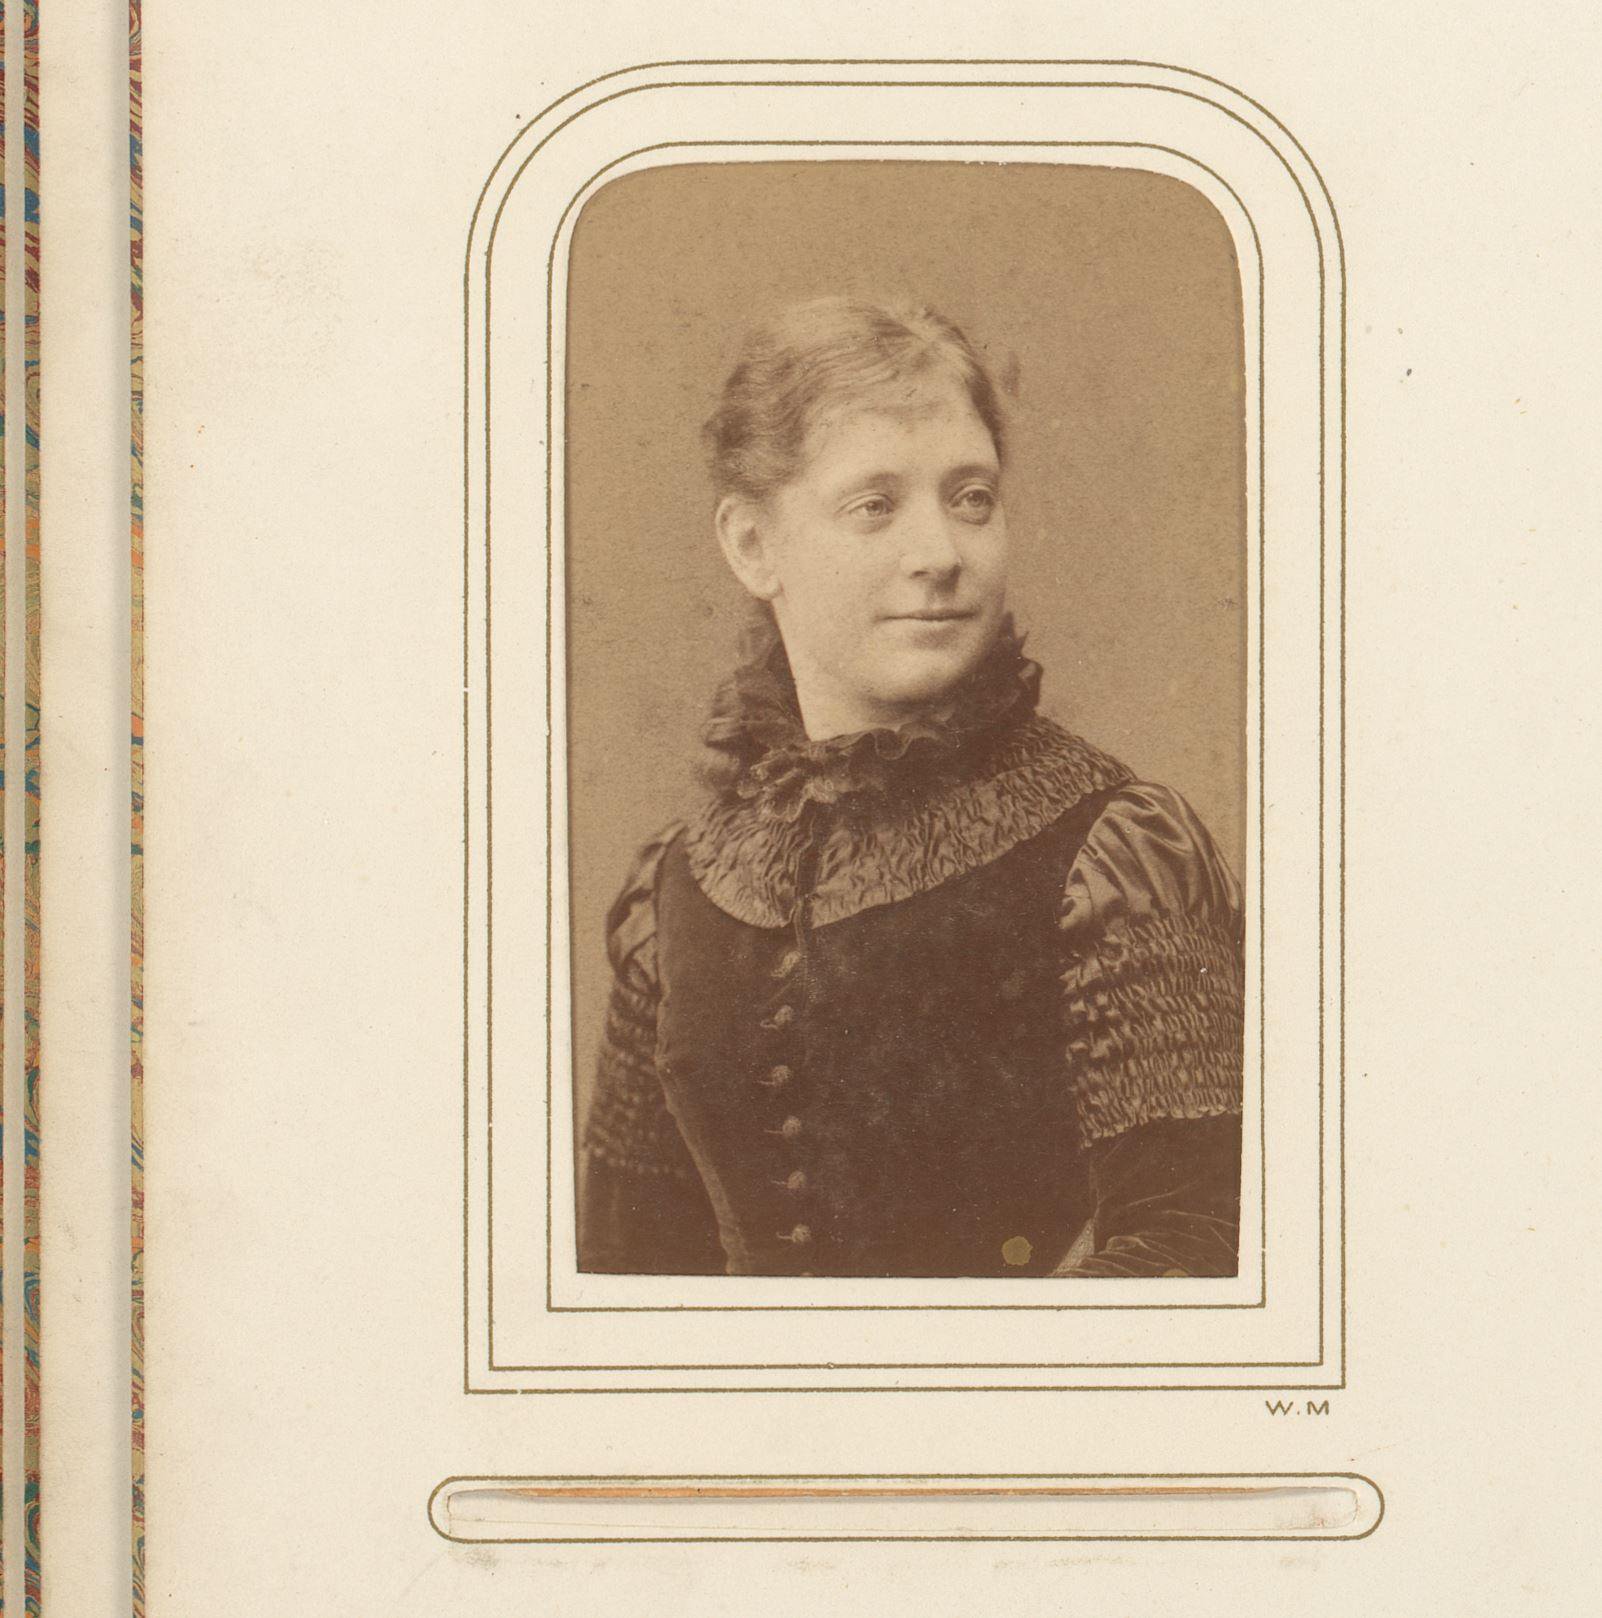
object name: album leaf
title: Portret van Lotten Dorsch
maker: gösta florman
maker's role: fotograaf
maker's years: 1831-1900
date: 1867-1885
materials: cardboard, photographic support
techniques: albumen print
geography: stockholm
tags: historical persons - bb - woman, portrait of actor, actress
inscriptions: annotation: ‘Lotten Dorsch/ 1849 - 1908.’, inscription: ‘Gösta Florman/ STOCKHOLM/ 28A Regeringsgatan 28 A.’